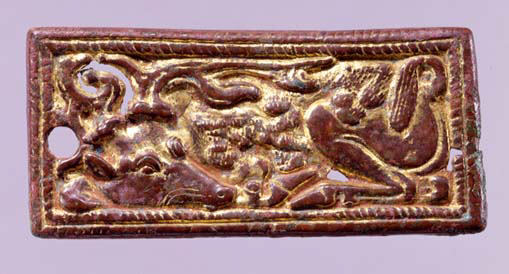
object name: belt buckle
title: Belt Buckle with Recumbent Stags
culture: north chinese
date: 200-101 BCE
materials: bronze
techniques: gilding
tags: animals